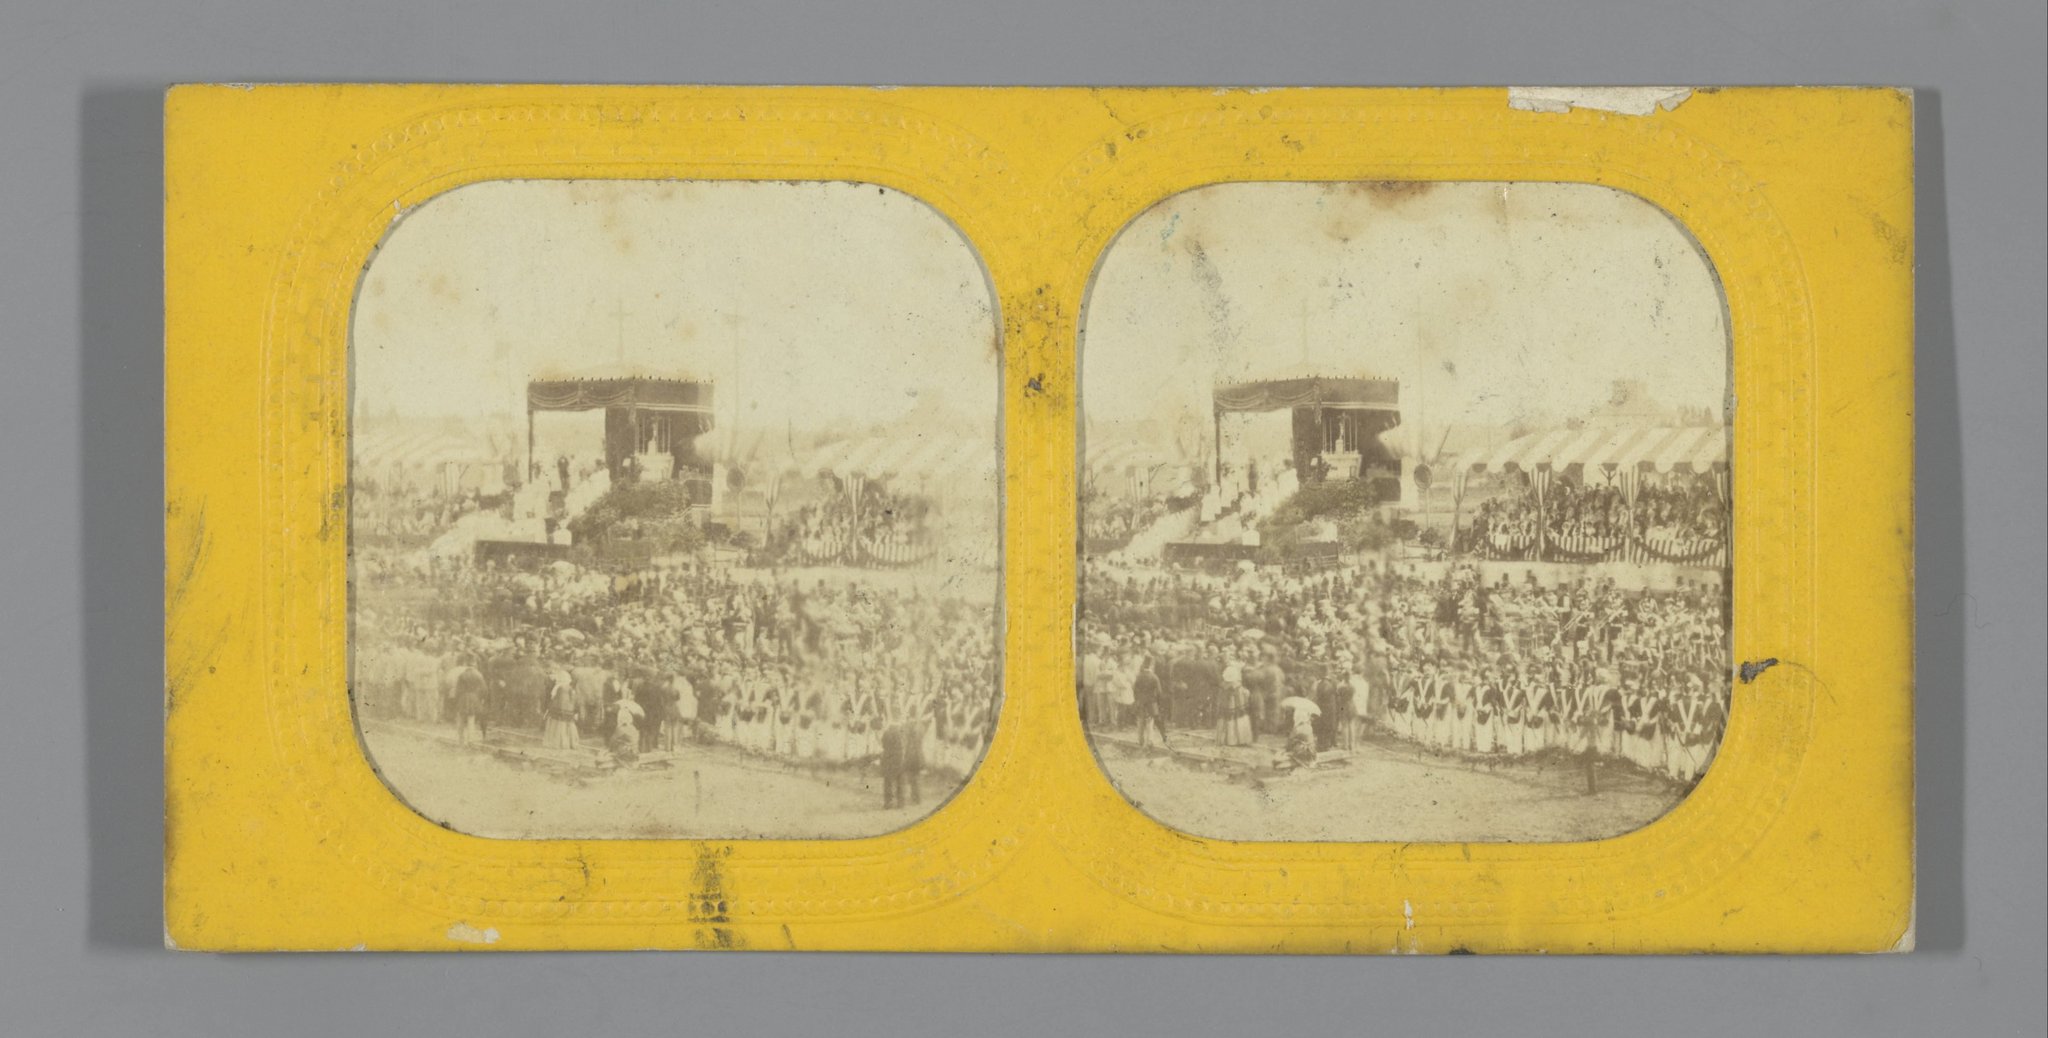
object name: tissue stereograph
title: Publiek rond baldakijn met altaar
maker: Anonymous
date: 1855-1875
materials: cardboard, paper, photographic support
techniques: albumen print, hand coloring, perforating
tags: altar under altar-canopy or ciborium